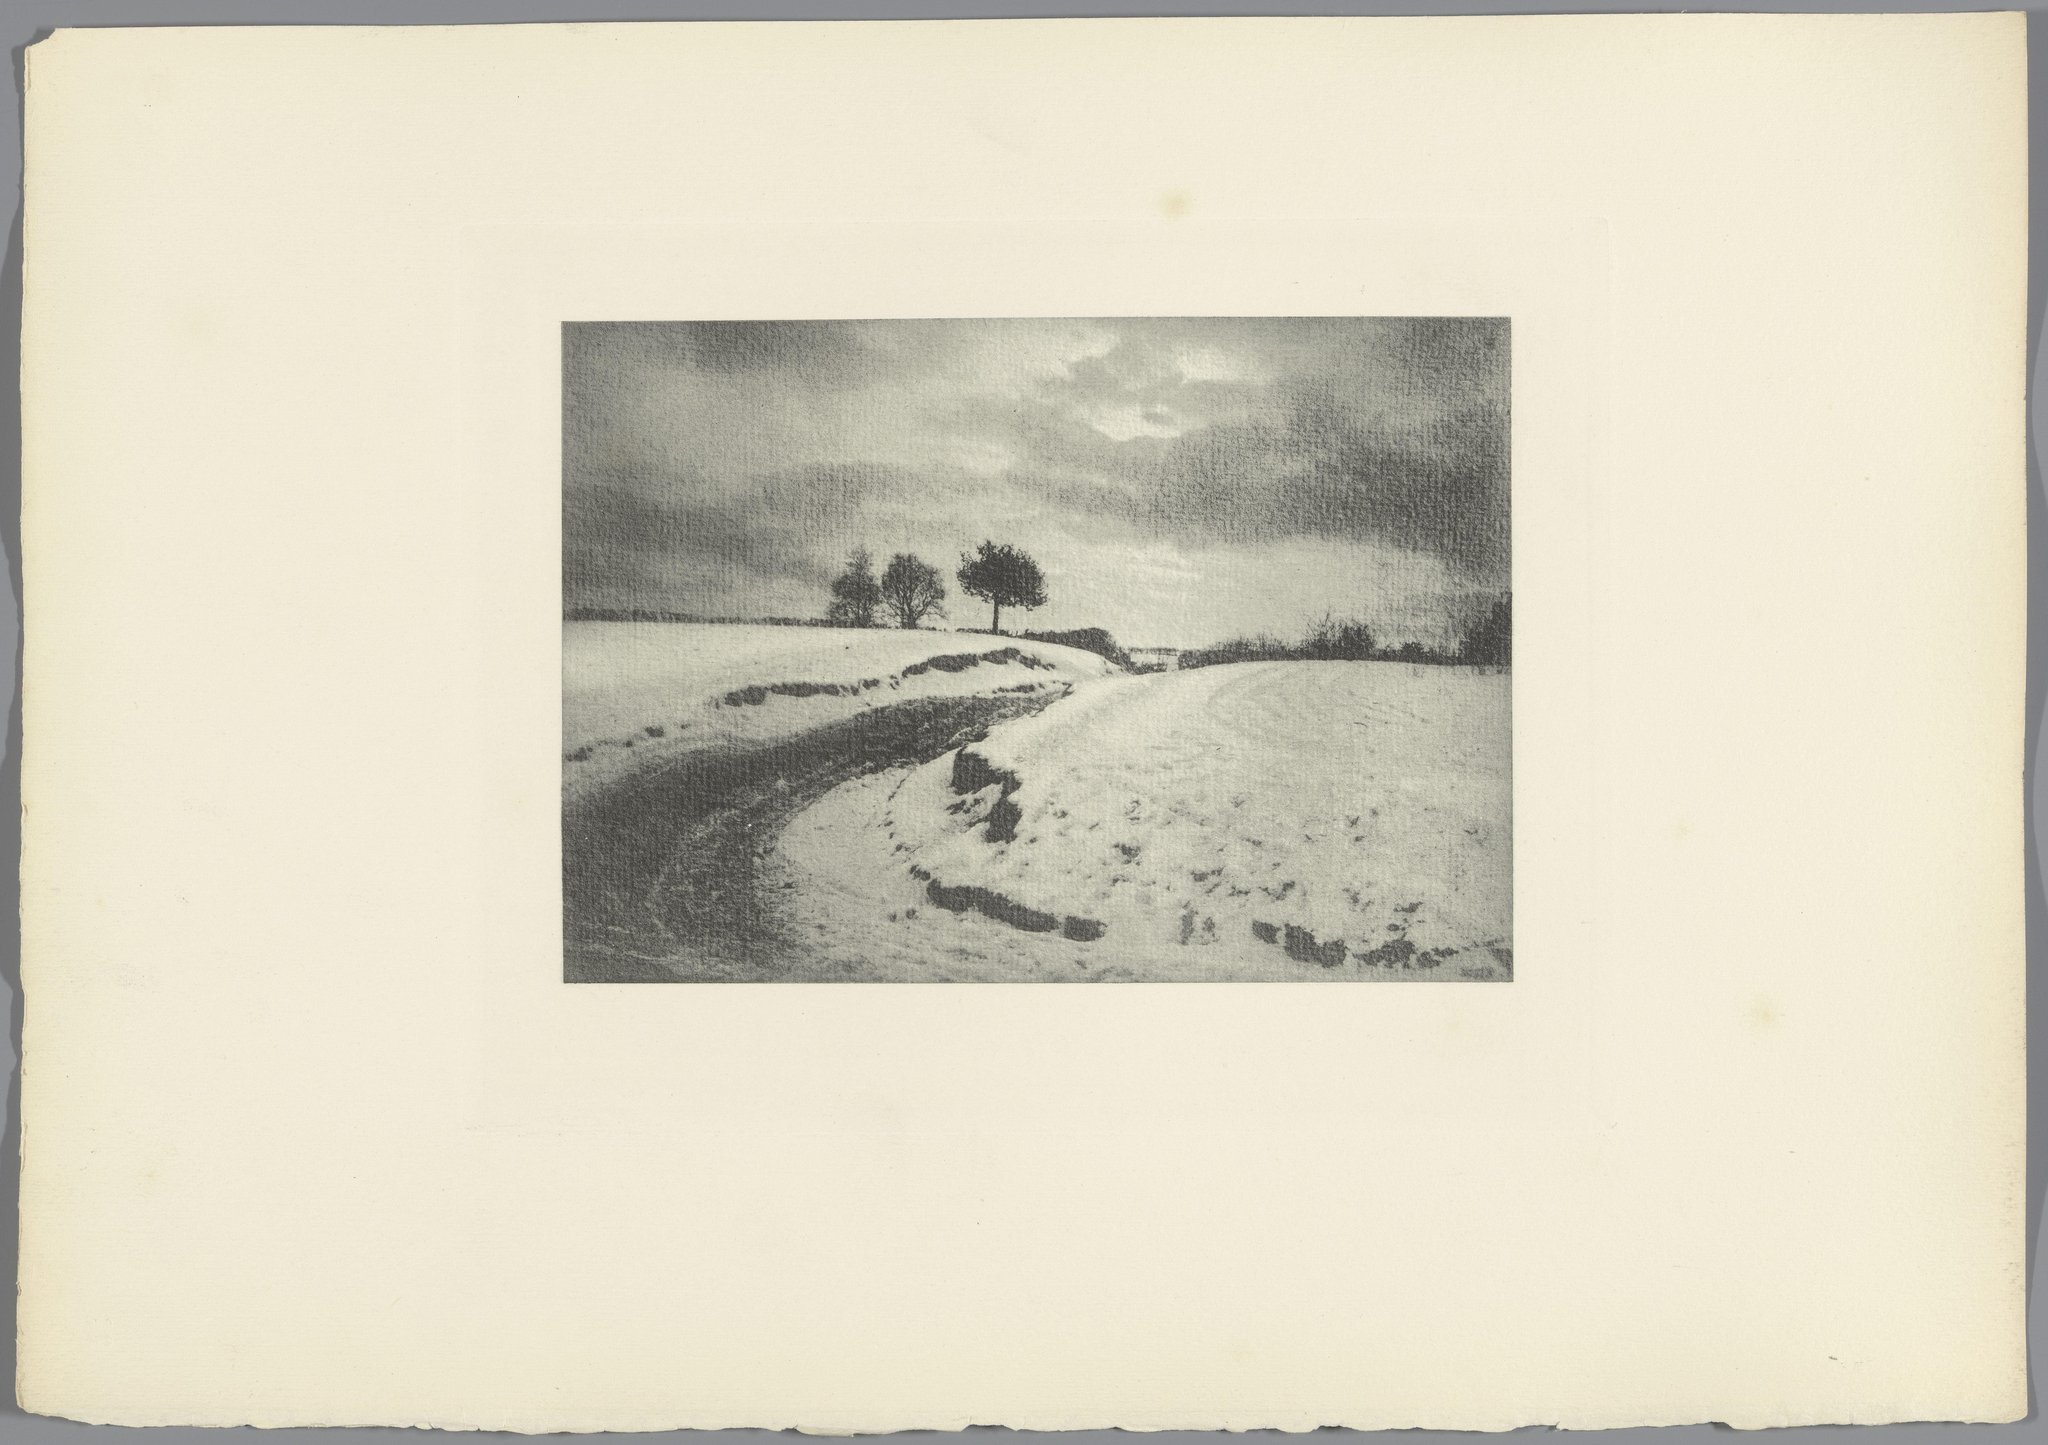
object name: photomechanical print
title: Une route de campagne en hiver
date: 1891-1896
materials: paper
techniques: photoaquatint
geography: paris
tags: low hill country, road, path, winter landscape; landscape symbolizing winter (the four seasons of the year)